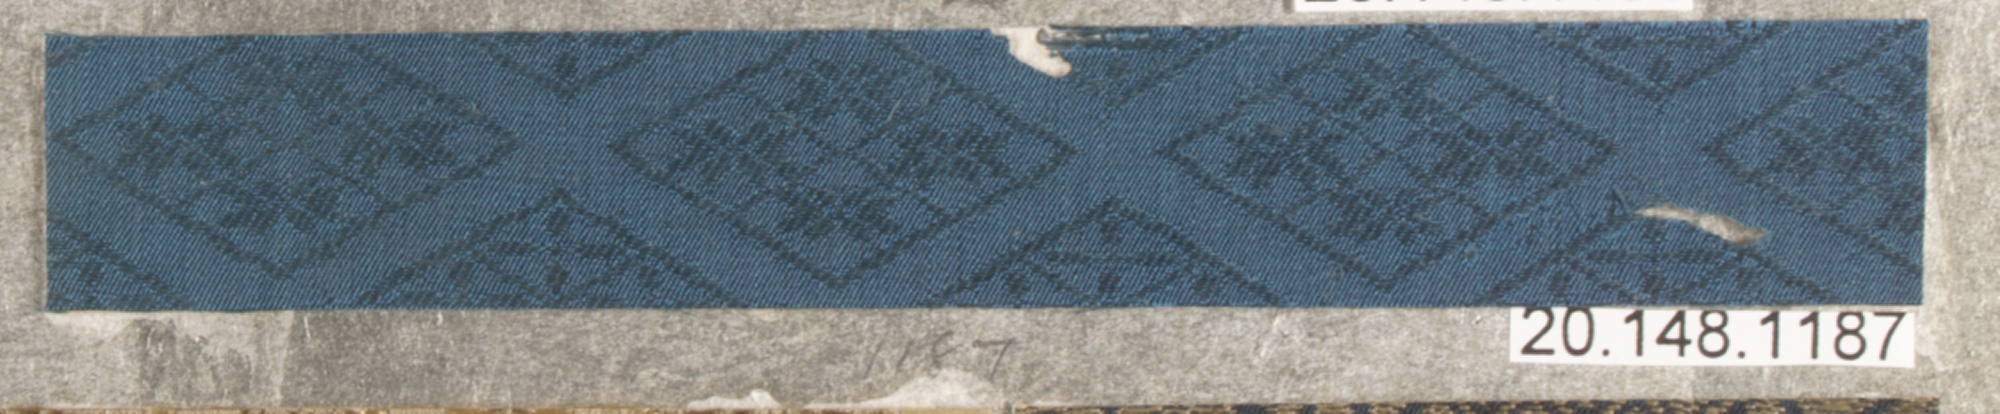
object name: piece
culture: japanese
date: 1701-1800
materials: silk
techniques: compound weave